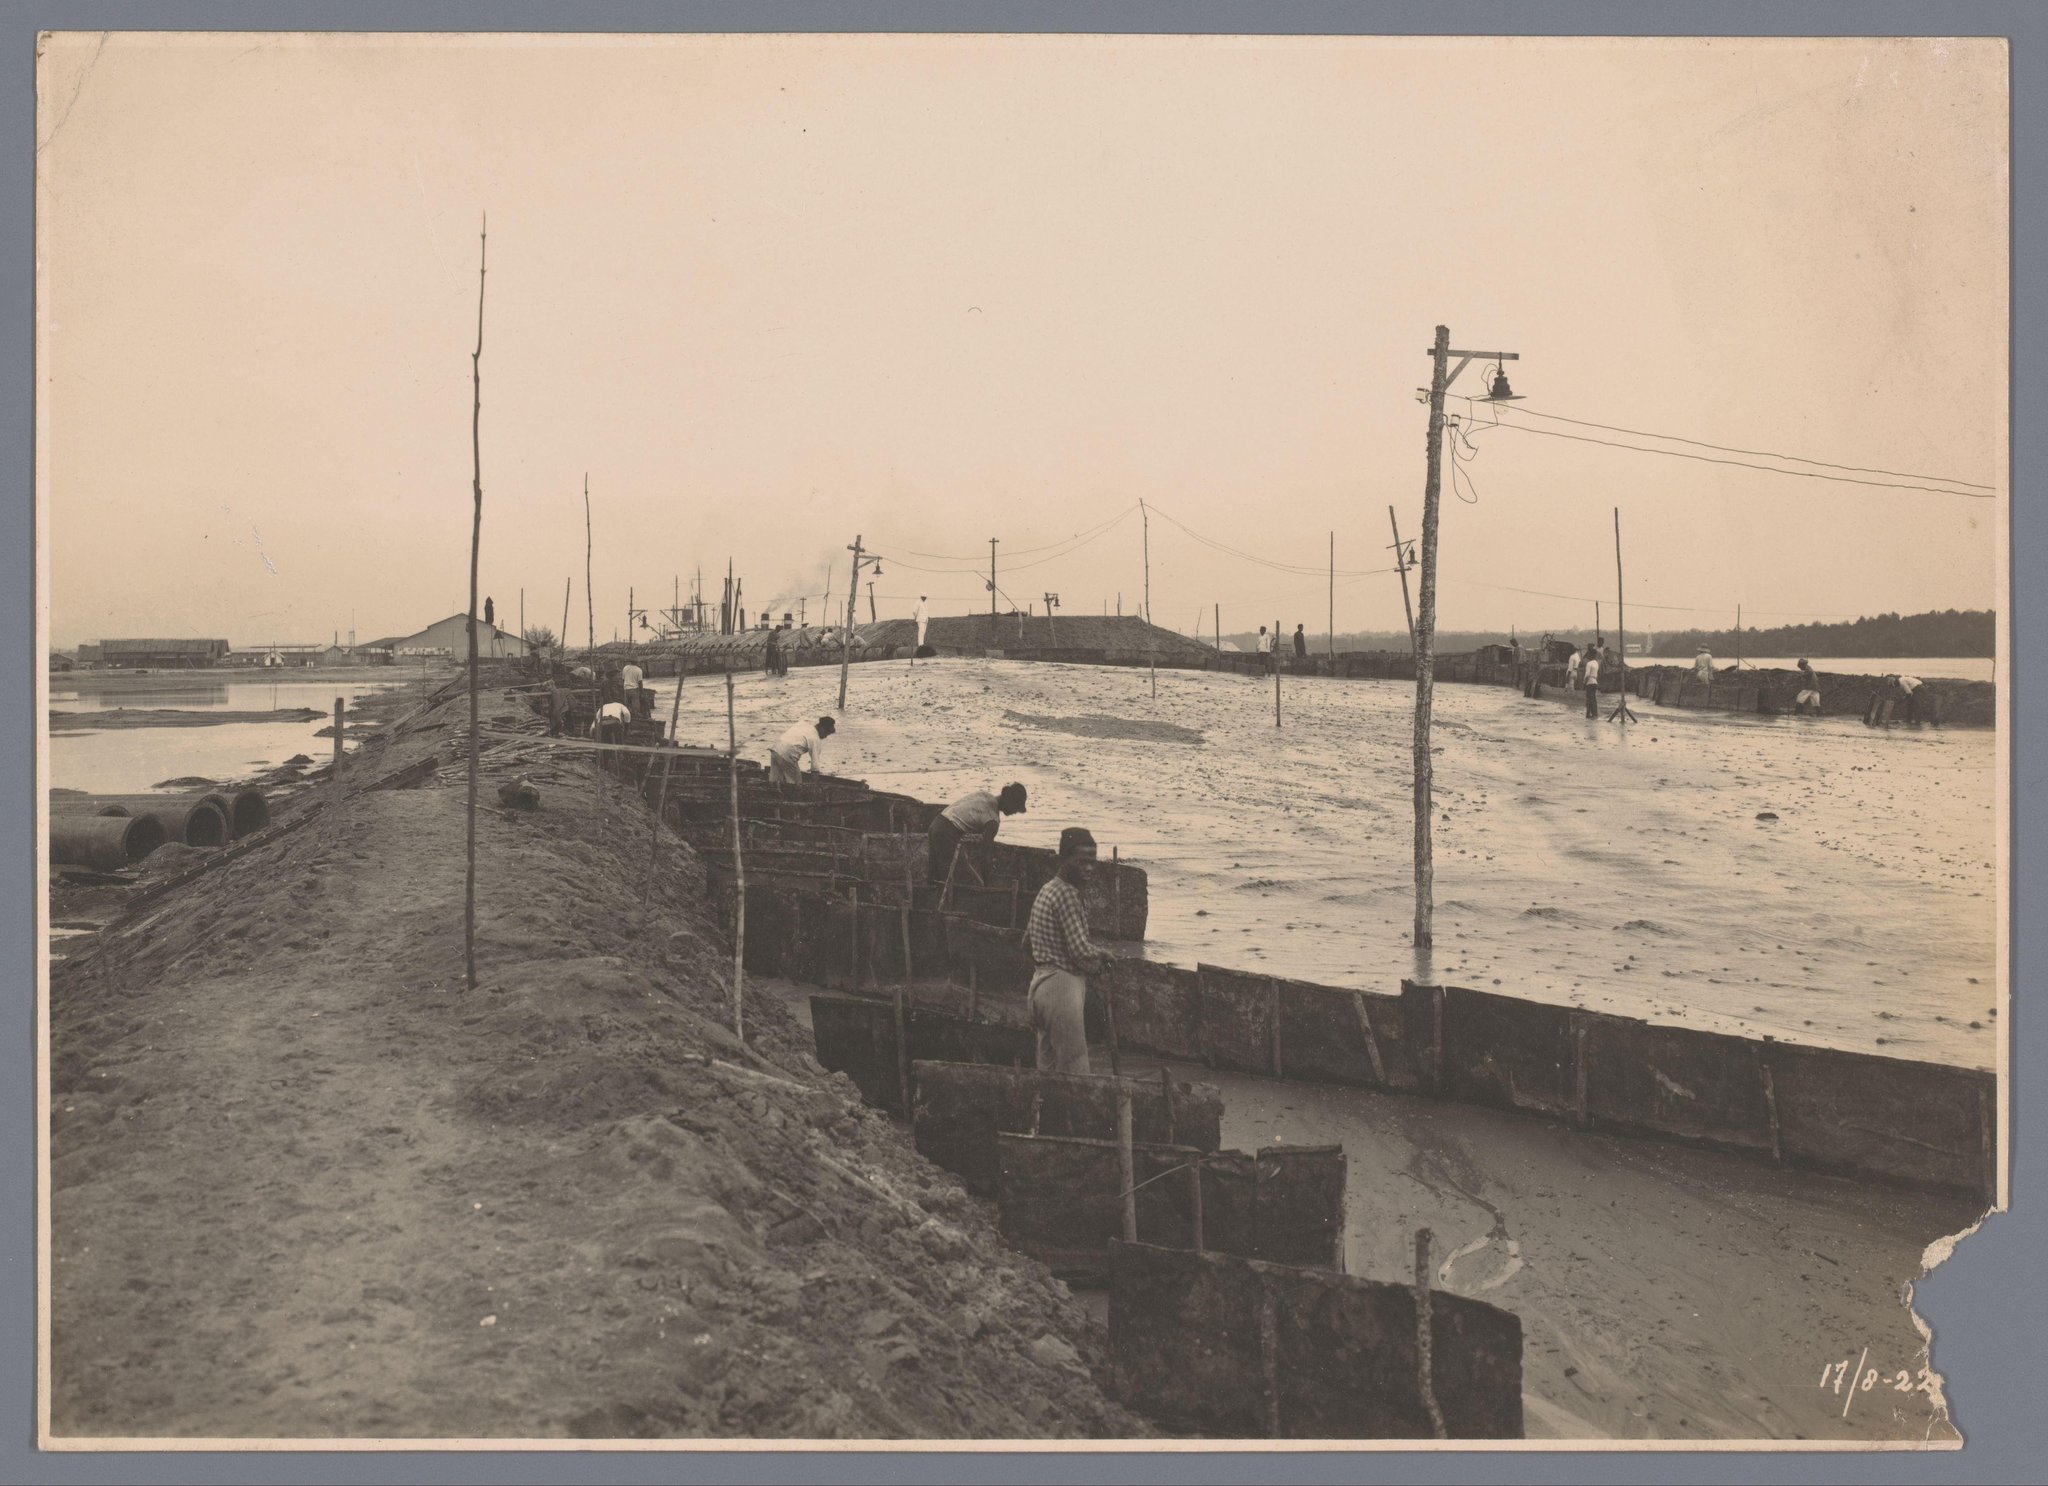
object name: photograph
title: Oceaanhaven Belawan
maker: Anonymous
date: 1922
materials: photographic support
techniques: gelatin silver print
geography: belawan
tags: harbour, building-site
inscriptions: annotation: ‘No. 188 idem 187’, date: ‘17/8-22’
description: Het opspuiten van zand. Genummerd: 188. Onderdeel van de groep van losse foto's over de aanleg van de haven Belawan aan de kust voor Medan, Sumatra 1921-1922.